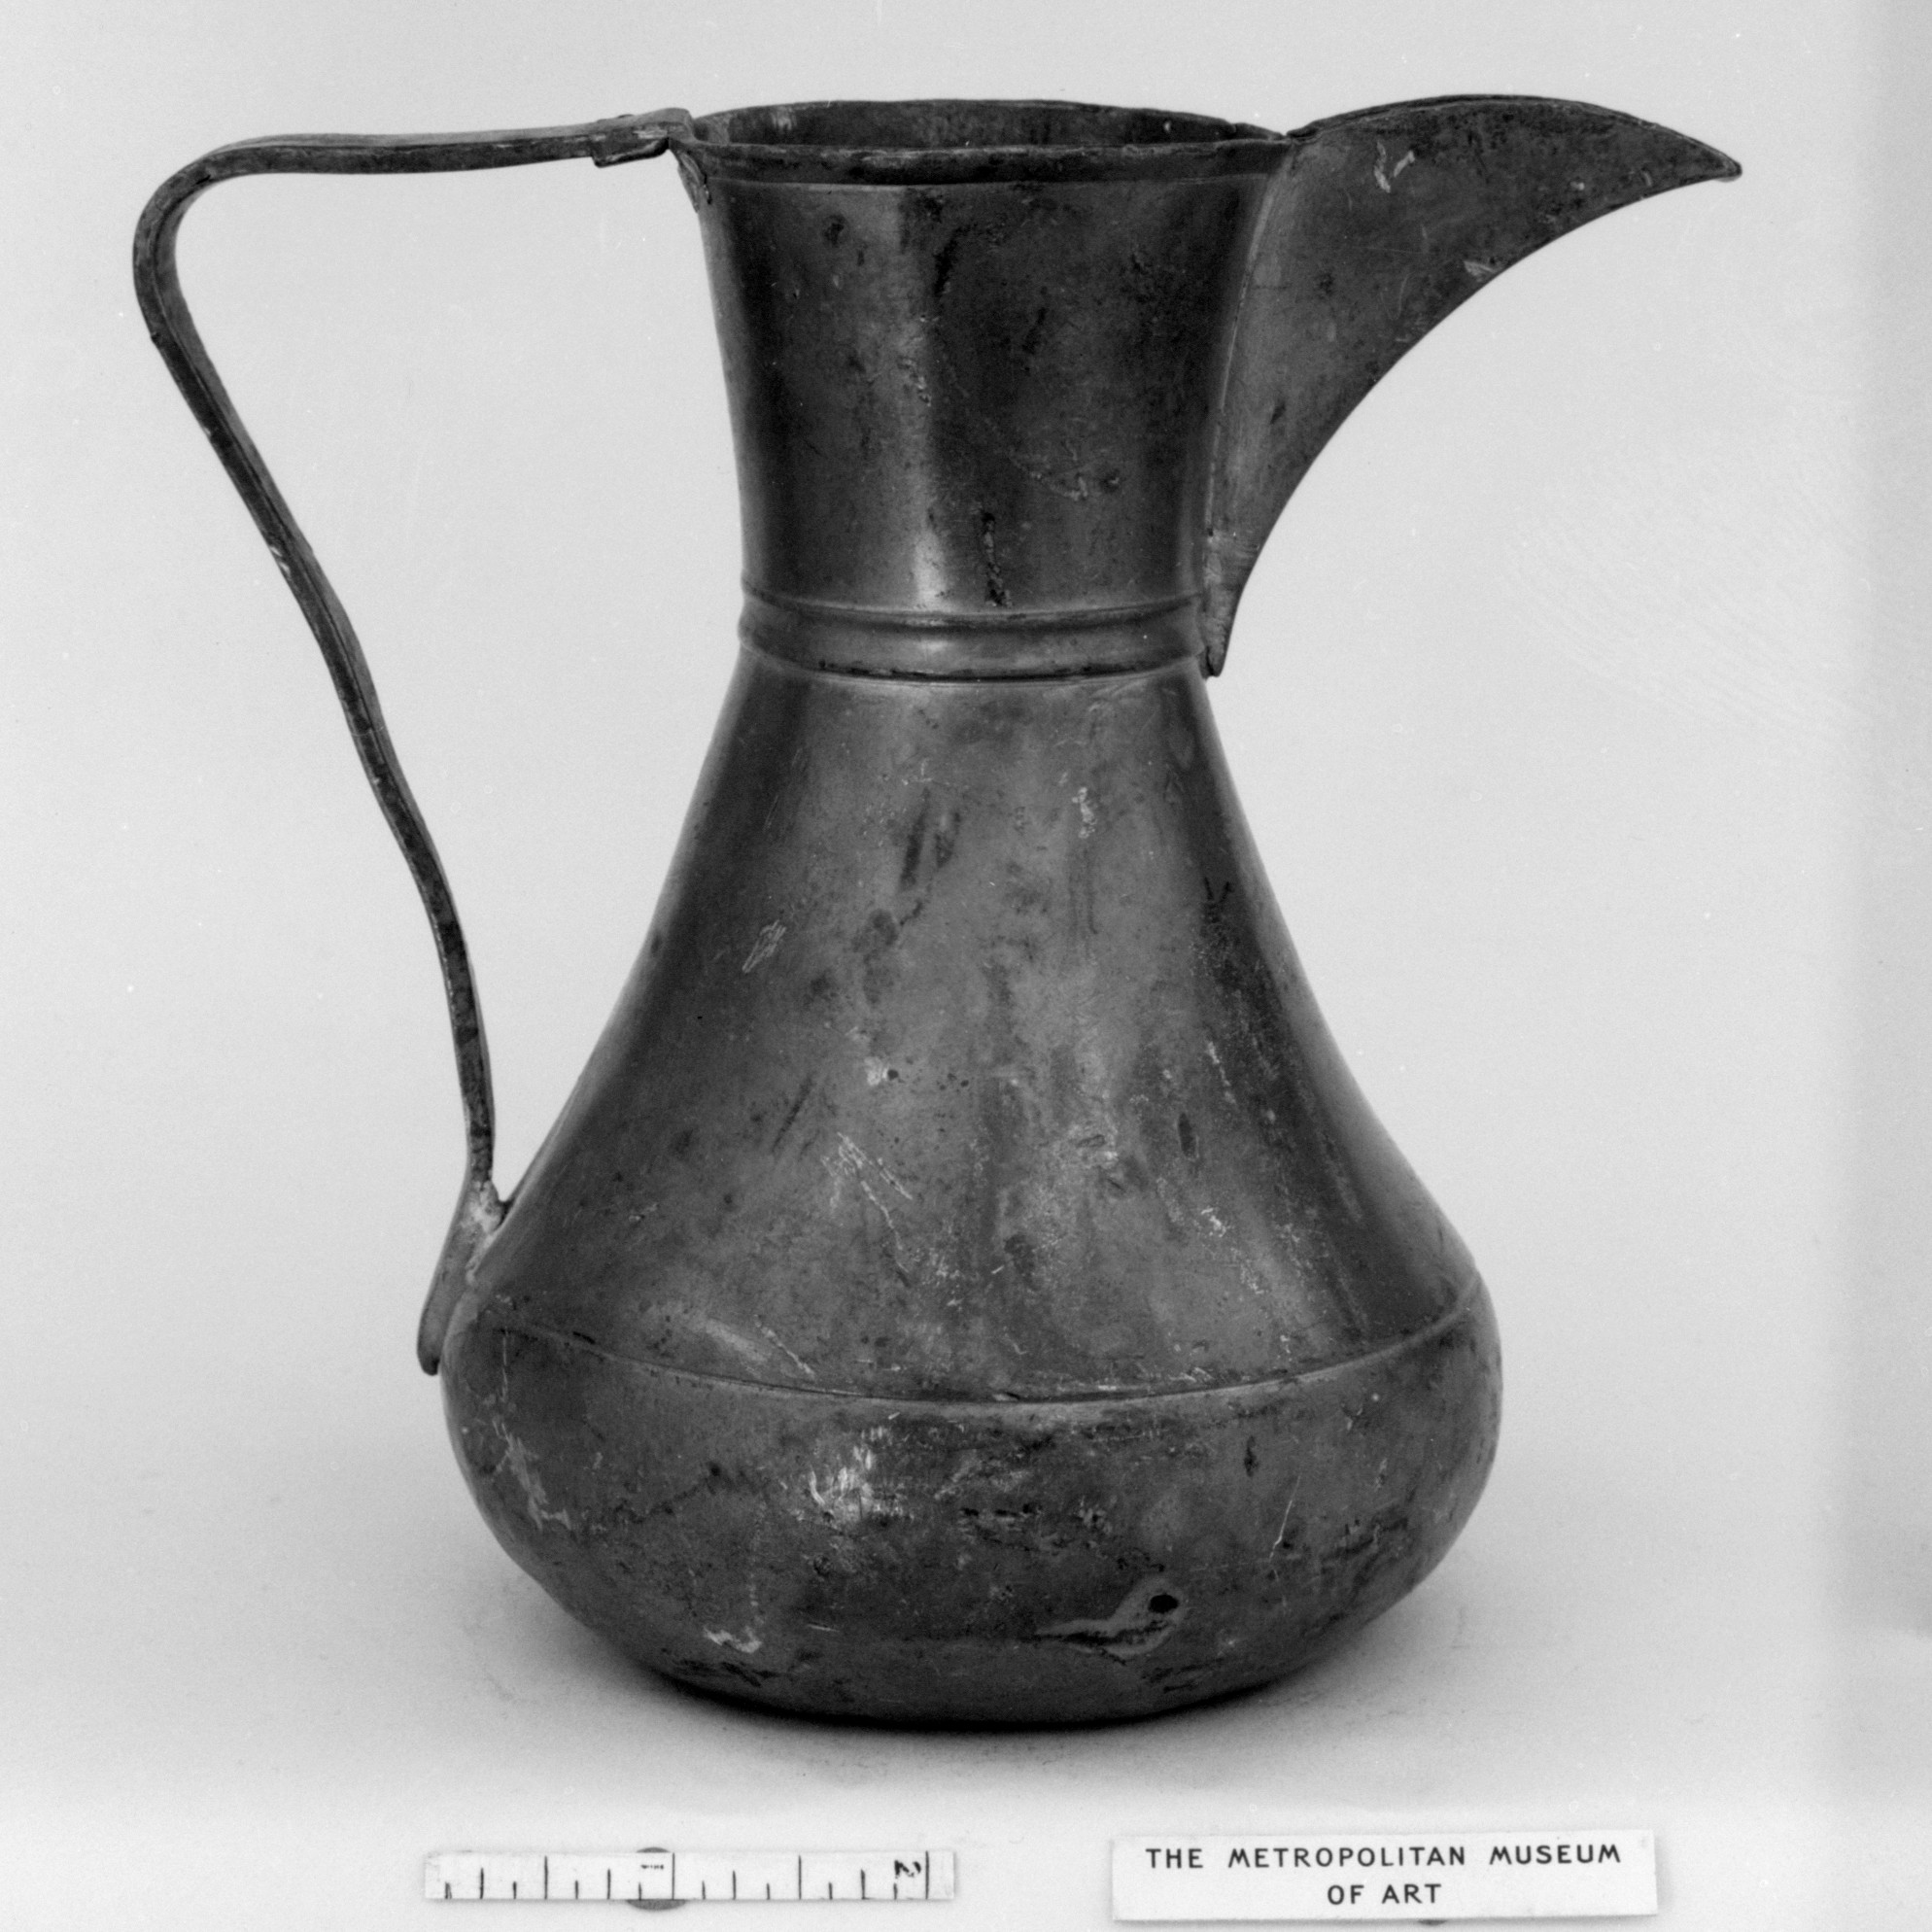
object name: ewer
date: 1567-1633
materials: pewter